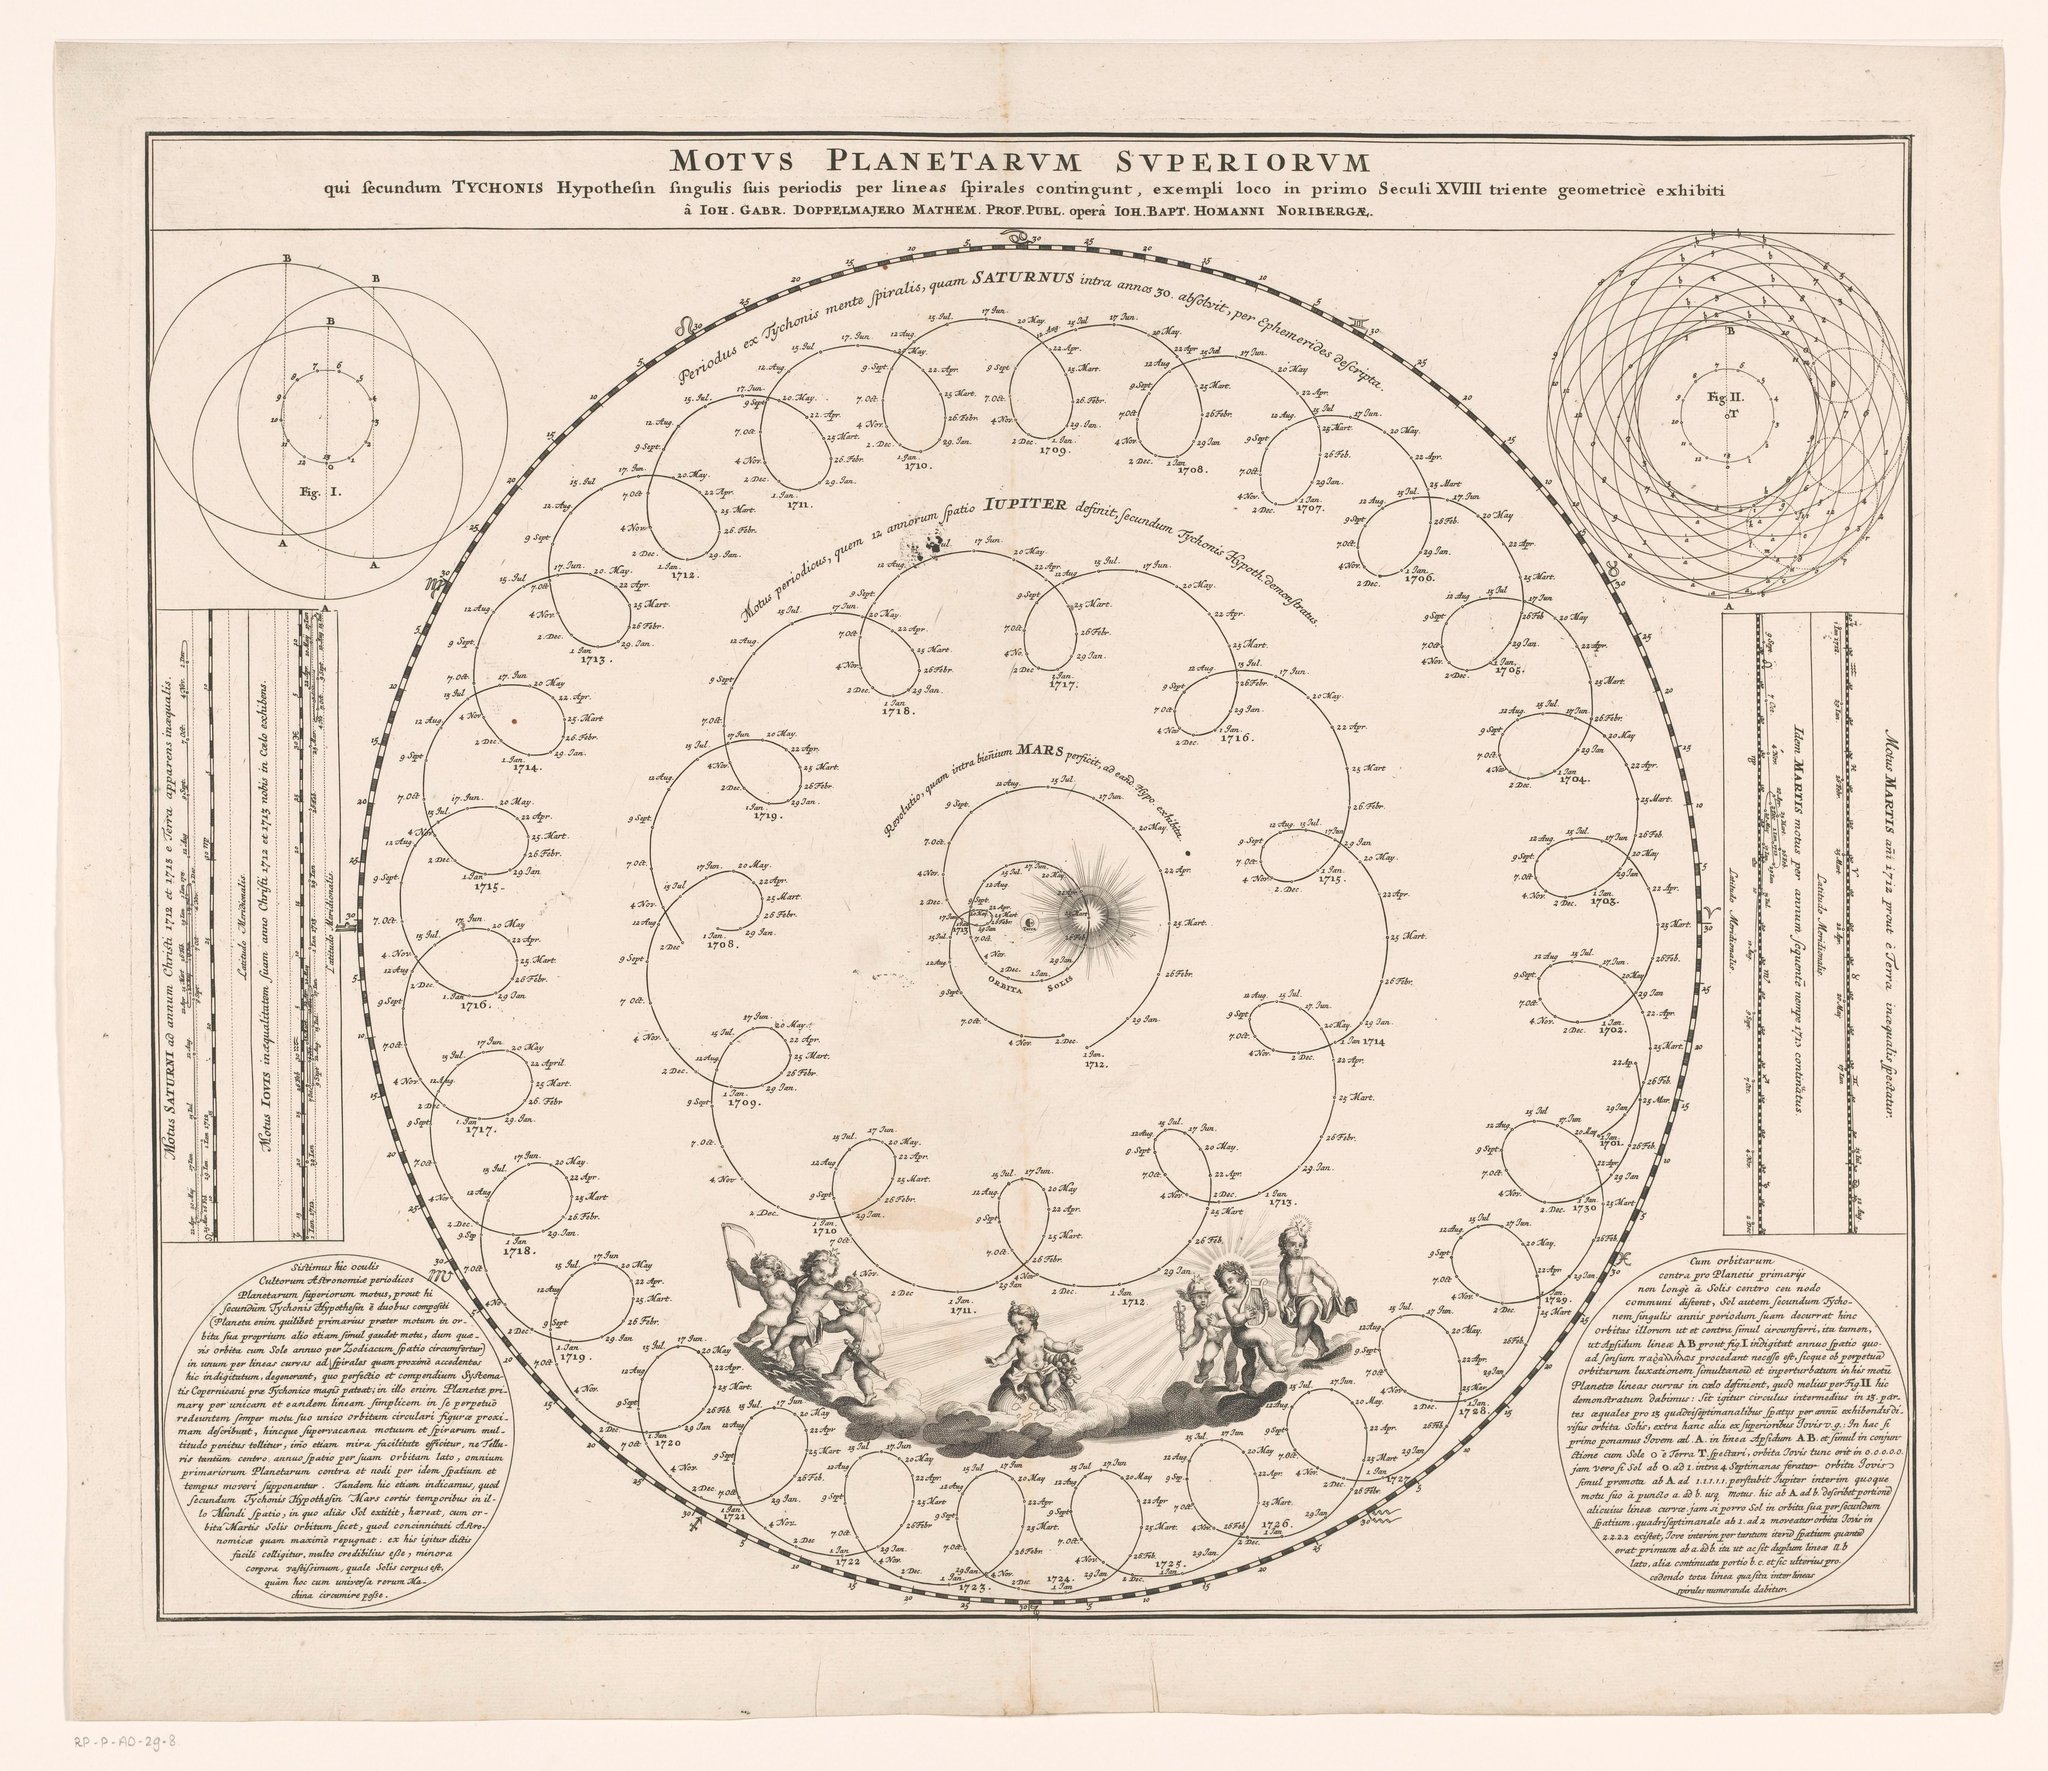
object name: print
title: Motus planetarus superiorum qui secundum Tychonis hypothesin (...)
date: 1702-1742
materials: paper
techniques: engraving, etching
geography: nuremberg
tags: earth, world as celestial body, planets; planetary system, solar system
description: Kaart met voorspelling van de banen van Mars, Jupiter en Saturnus, volgens Tycho Brahe's stelsel. De titel in een balk boven de kaart. Links- en rechtsboven figuren ter verduidelijking van de theorie. Links- en rechtsonder een bol met Latijnse tekst.